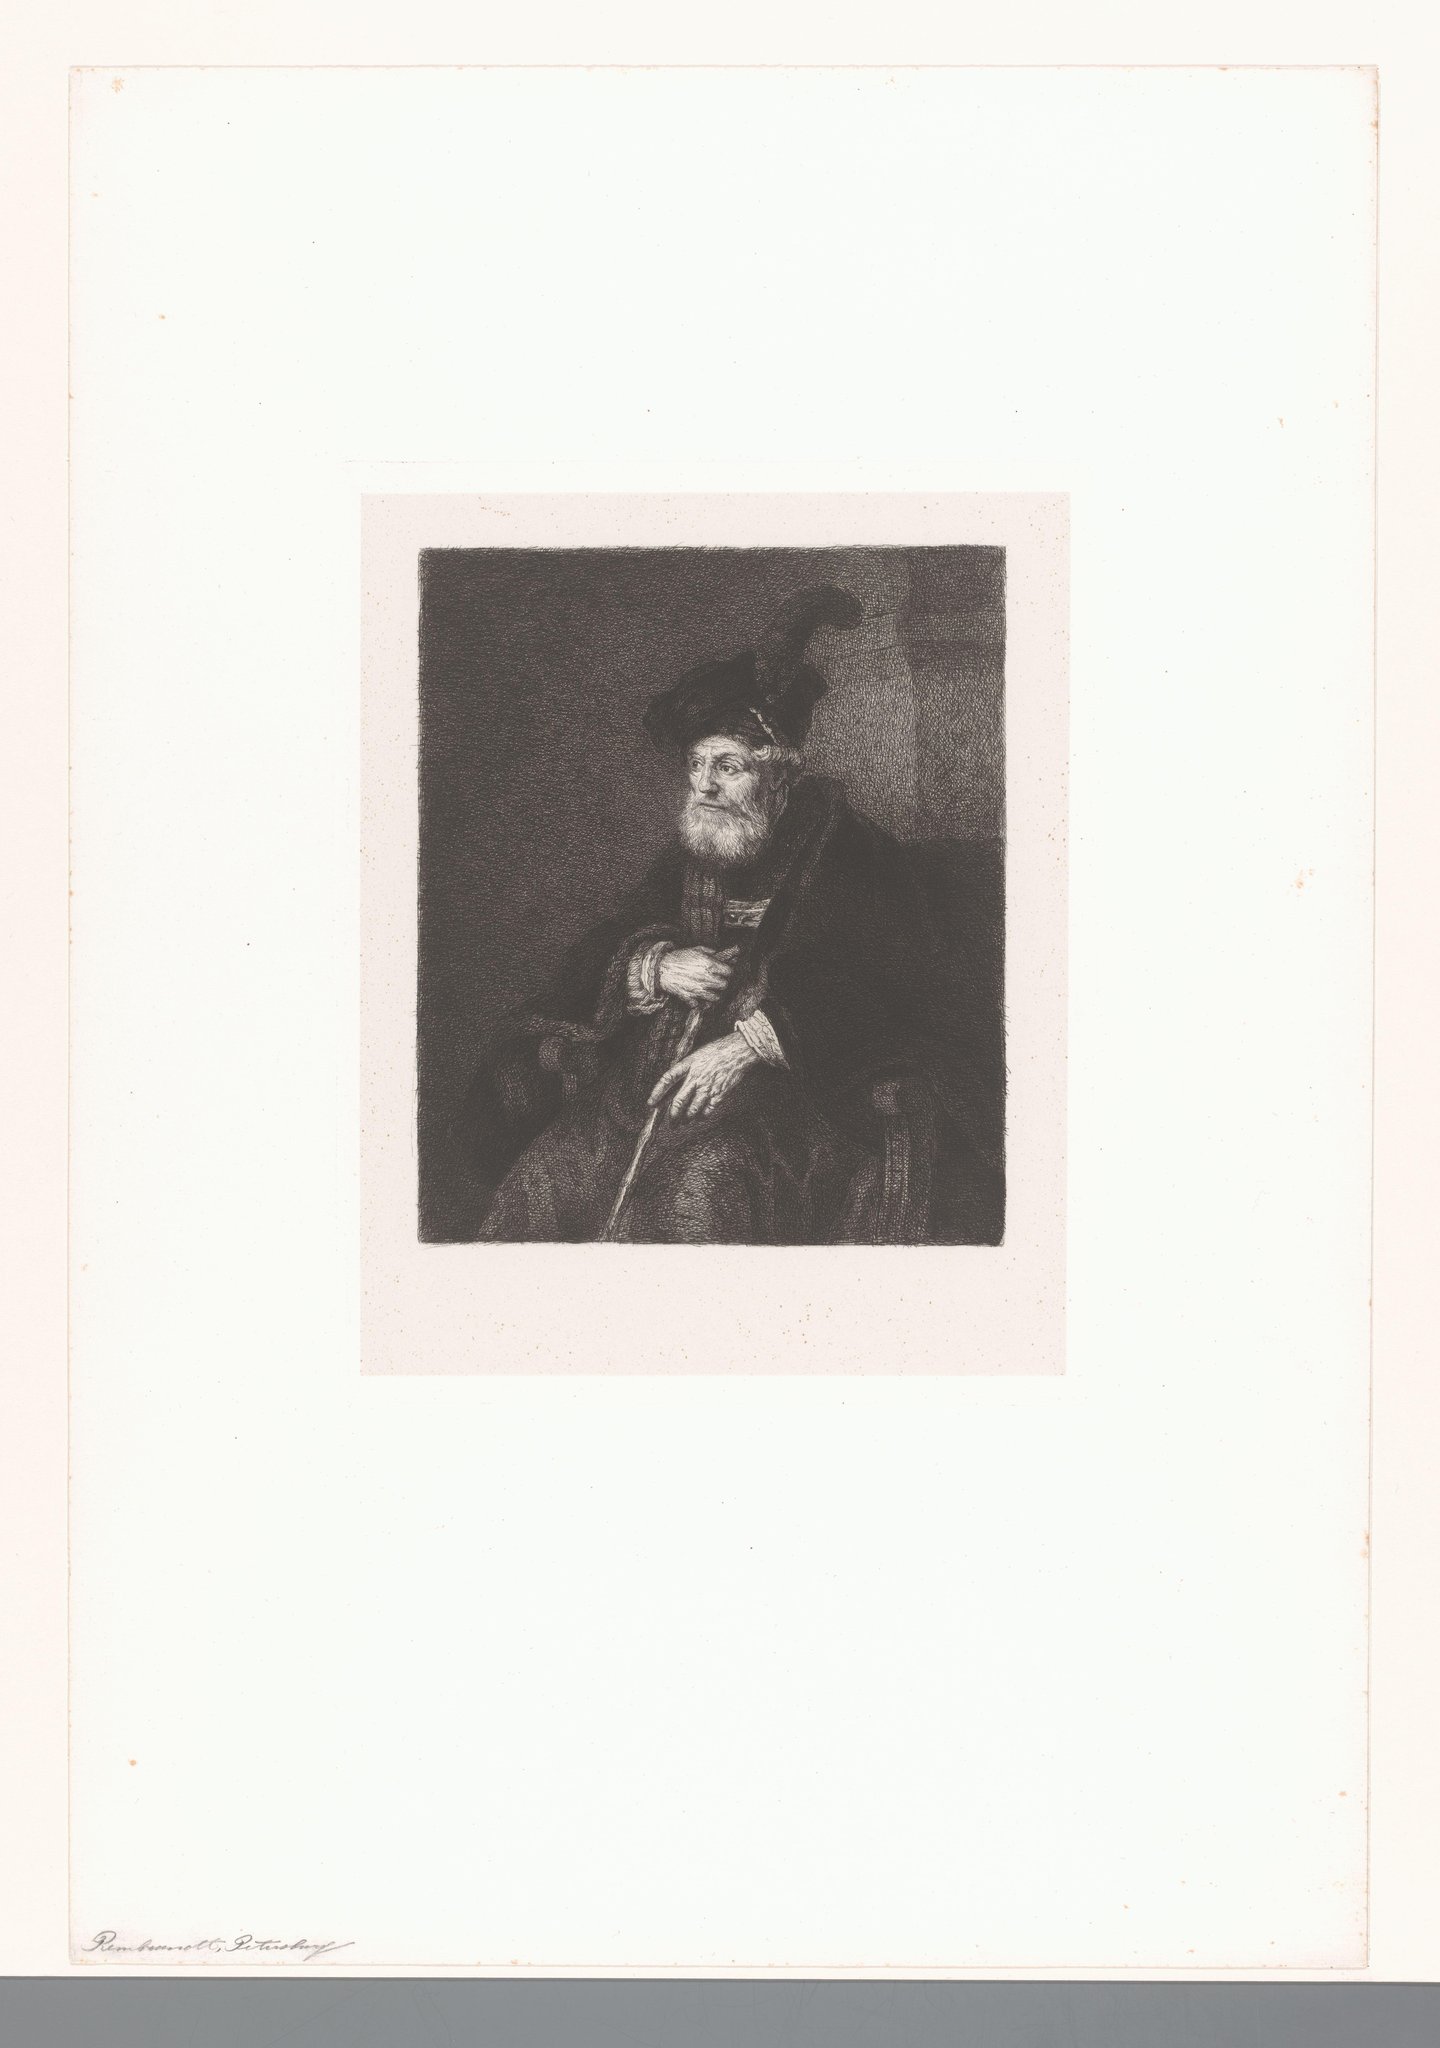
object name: print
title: Portret van oude man met baret met pluim en wandelstok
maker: nikolay semyonovich mosolov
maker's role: print maker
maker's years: 1847-1914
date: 1857-1914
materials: paper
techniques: drypoint, etching, intaglio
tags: walking-stick, staff, anonymous historical person portrayed alone, head-gear: beret